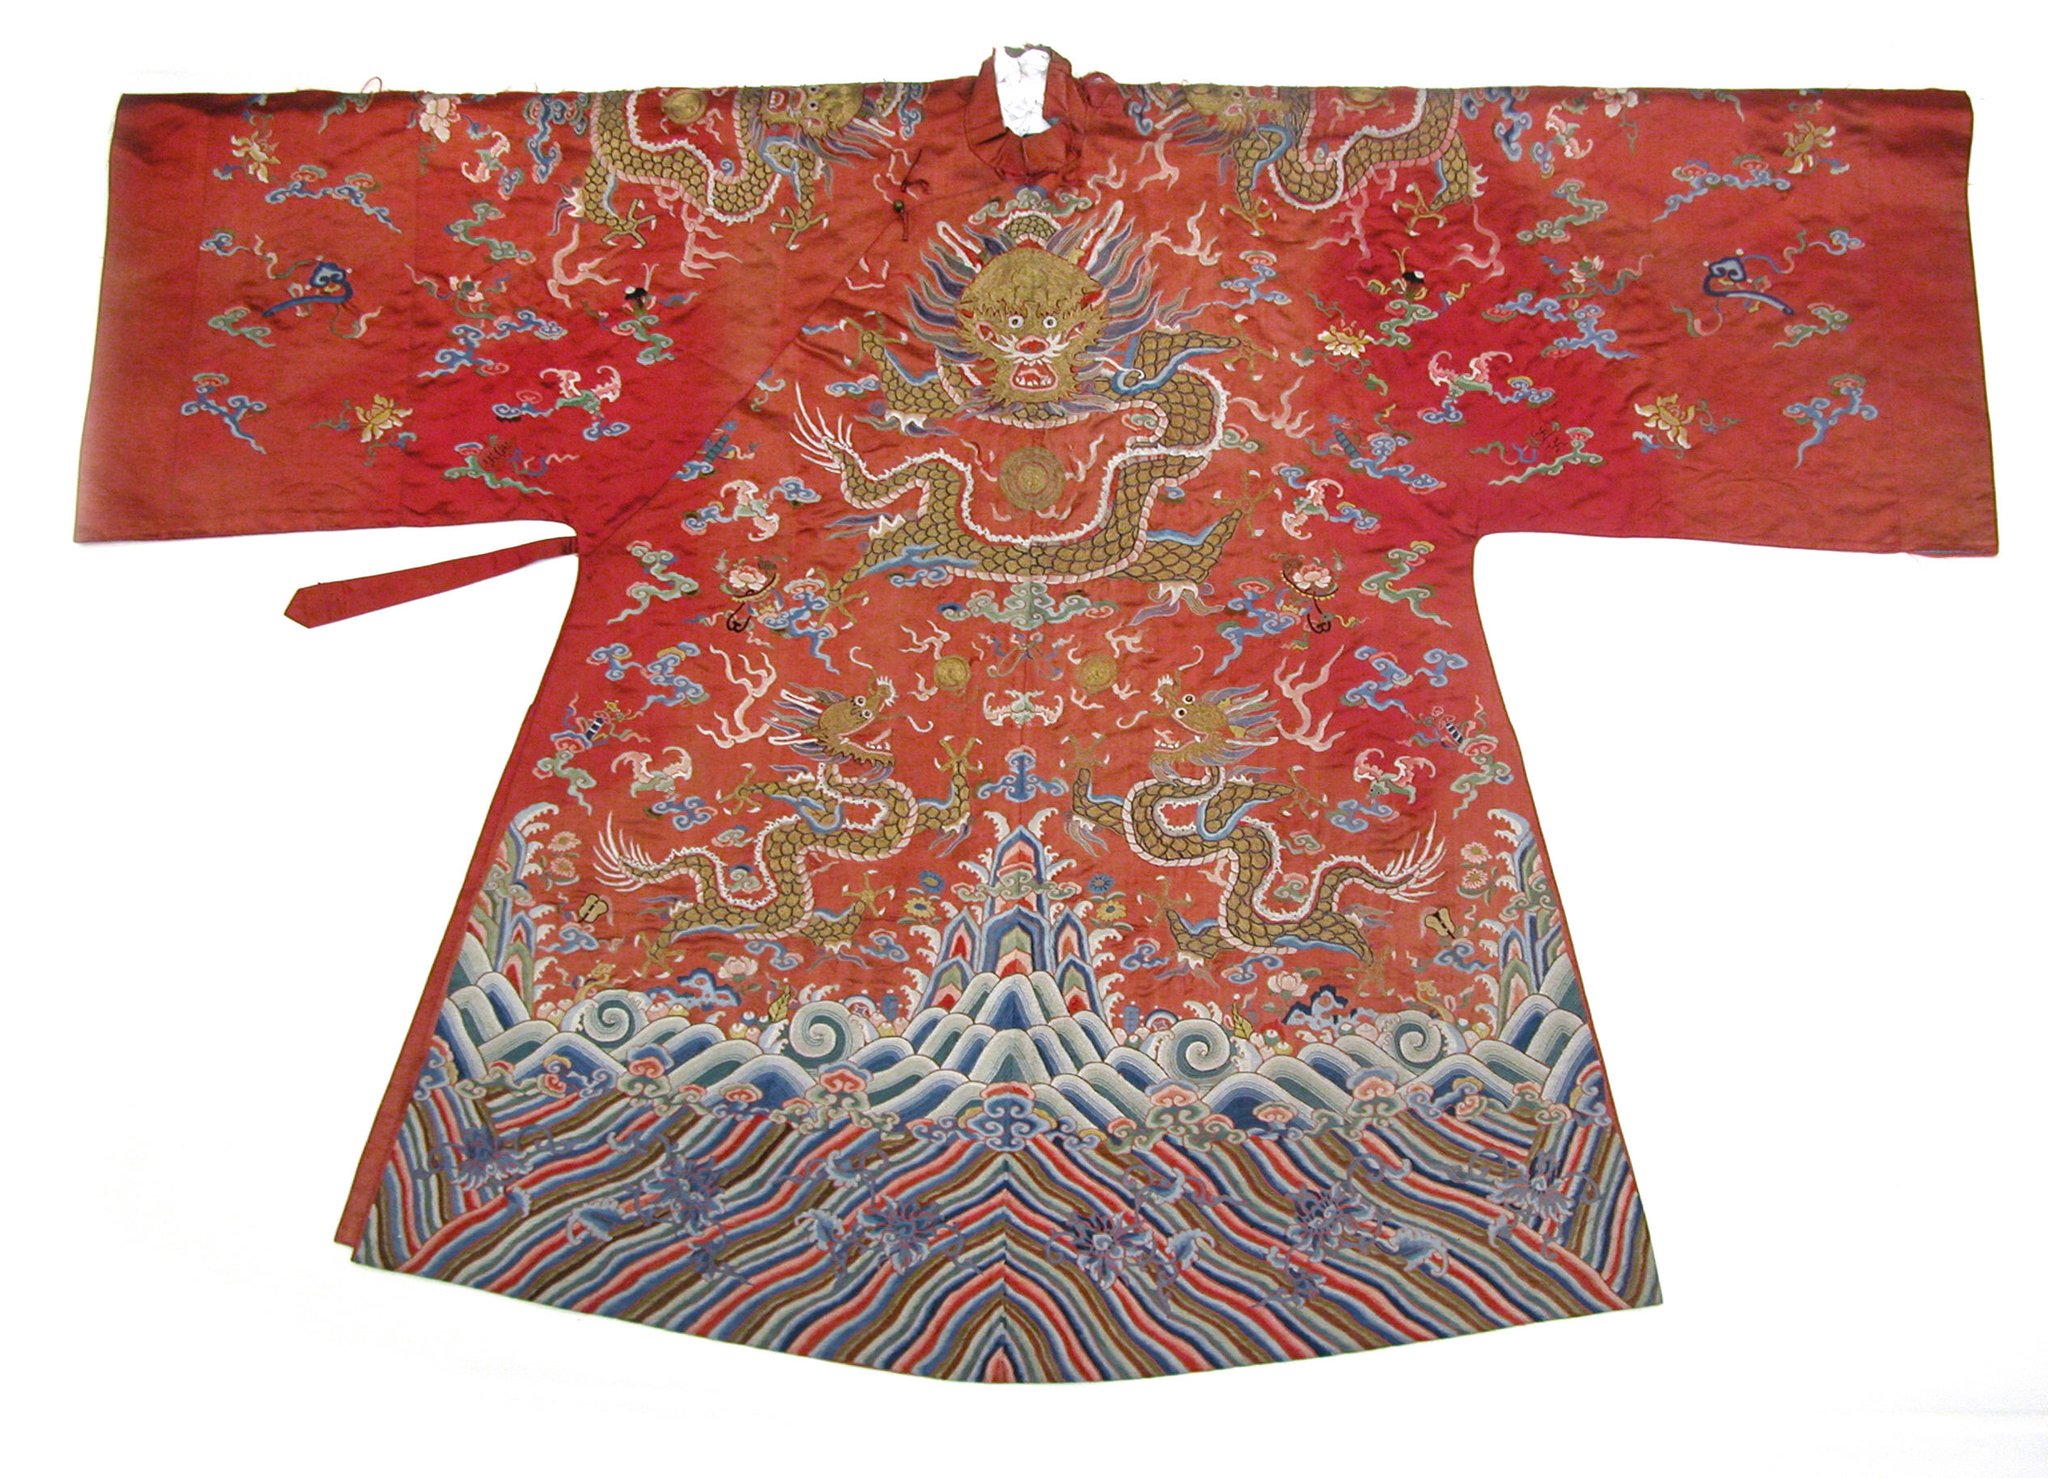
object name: woman's or men's wedding theatrical jacket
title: Man or Woman's Jacket, Wedding or Theatrical (?)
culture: chinese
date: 1701-1800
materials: silk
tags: dragons